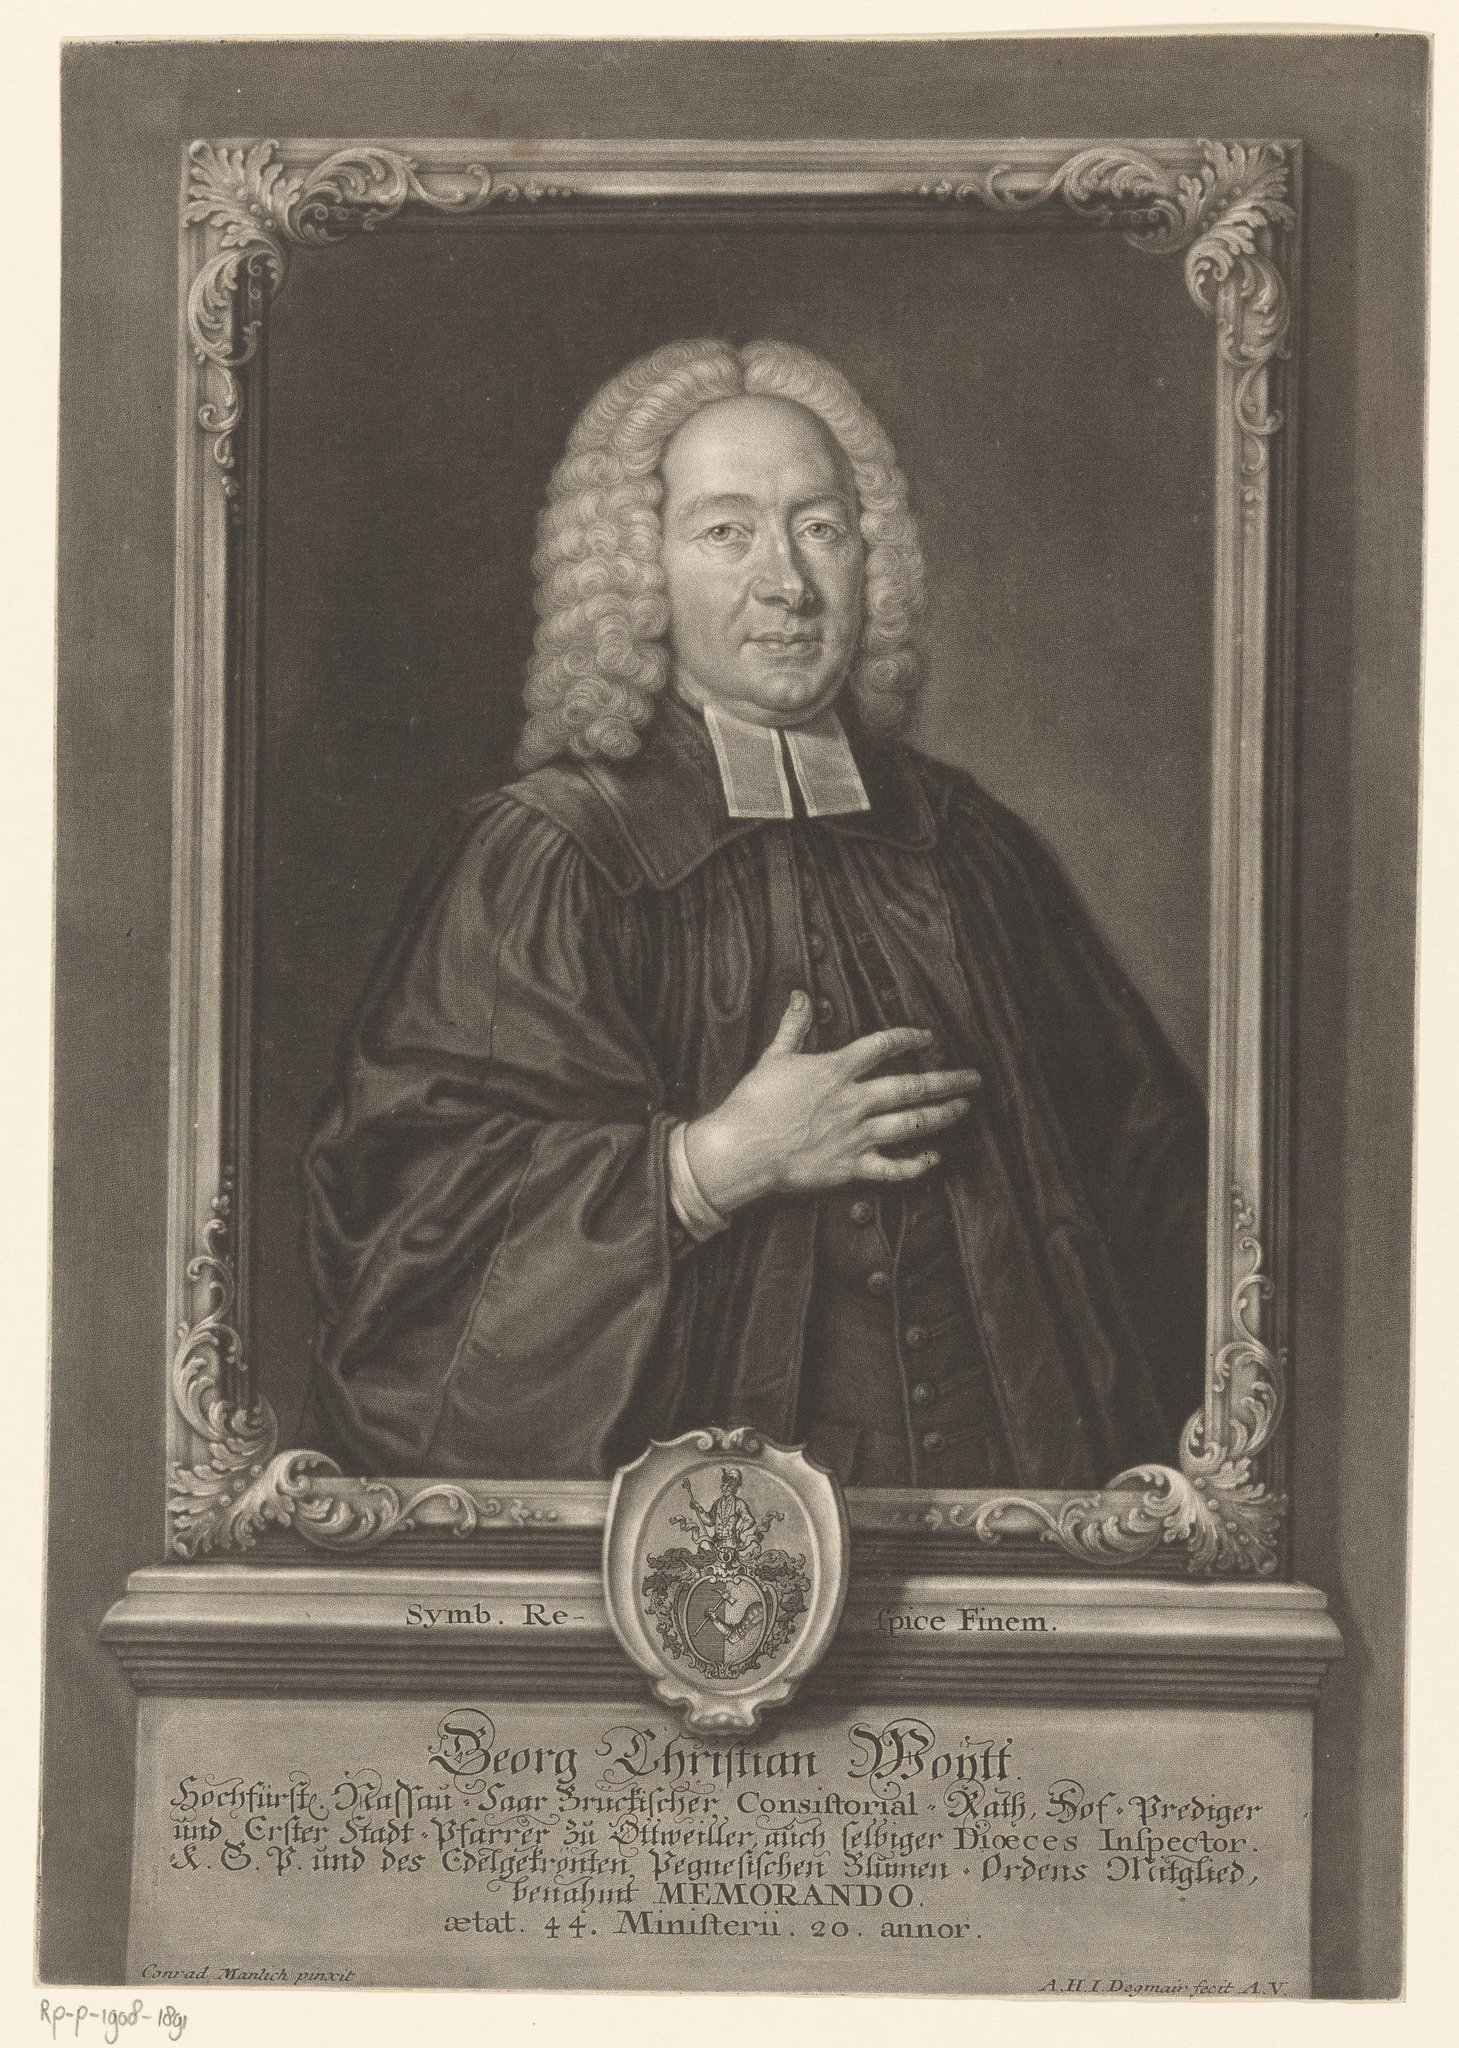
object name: print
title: Portret van Georg Christian Woytt op 44-jarige leeftijd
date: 1727-1783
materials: paper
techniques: mezzotint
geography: augsburg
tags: historical persons, armorial bearing, heraldry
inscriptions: collector's mark: Lugt 2228